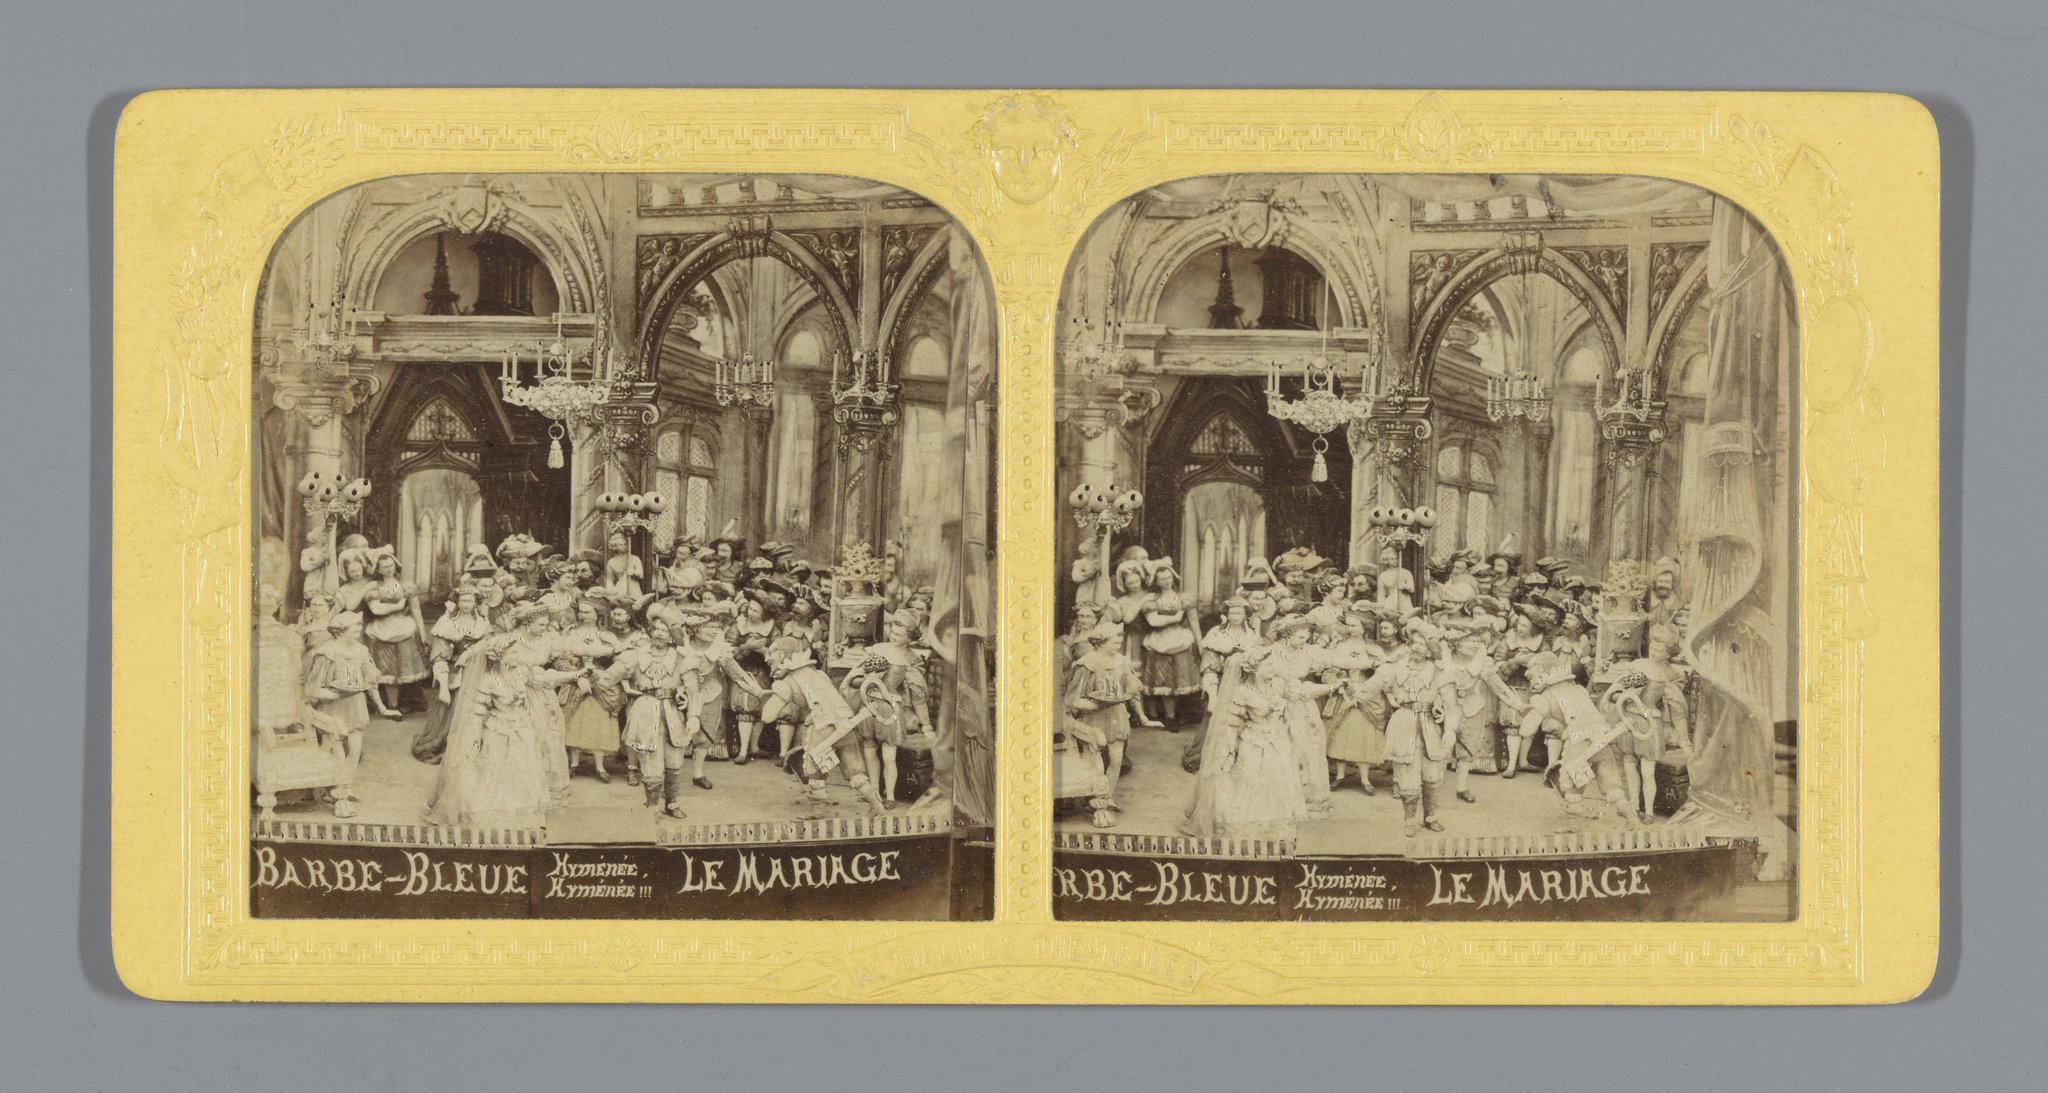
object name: stereograph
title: Stereofoto van het theater in Parijs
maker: Anonymous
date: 1867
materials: cardboard, photographic support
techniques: albumen print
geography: paris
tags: group of actors, troupe; actors on the stage, paris